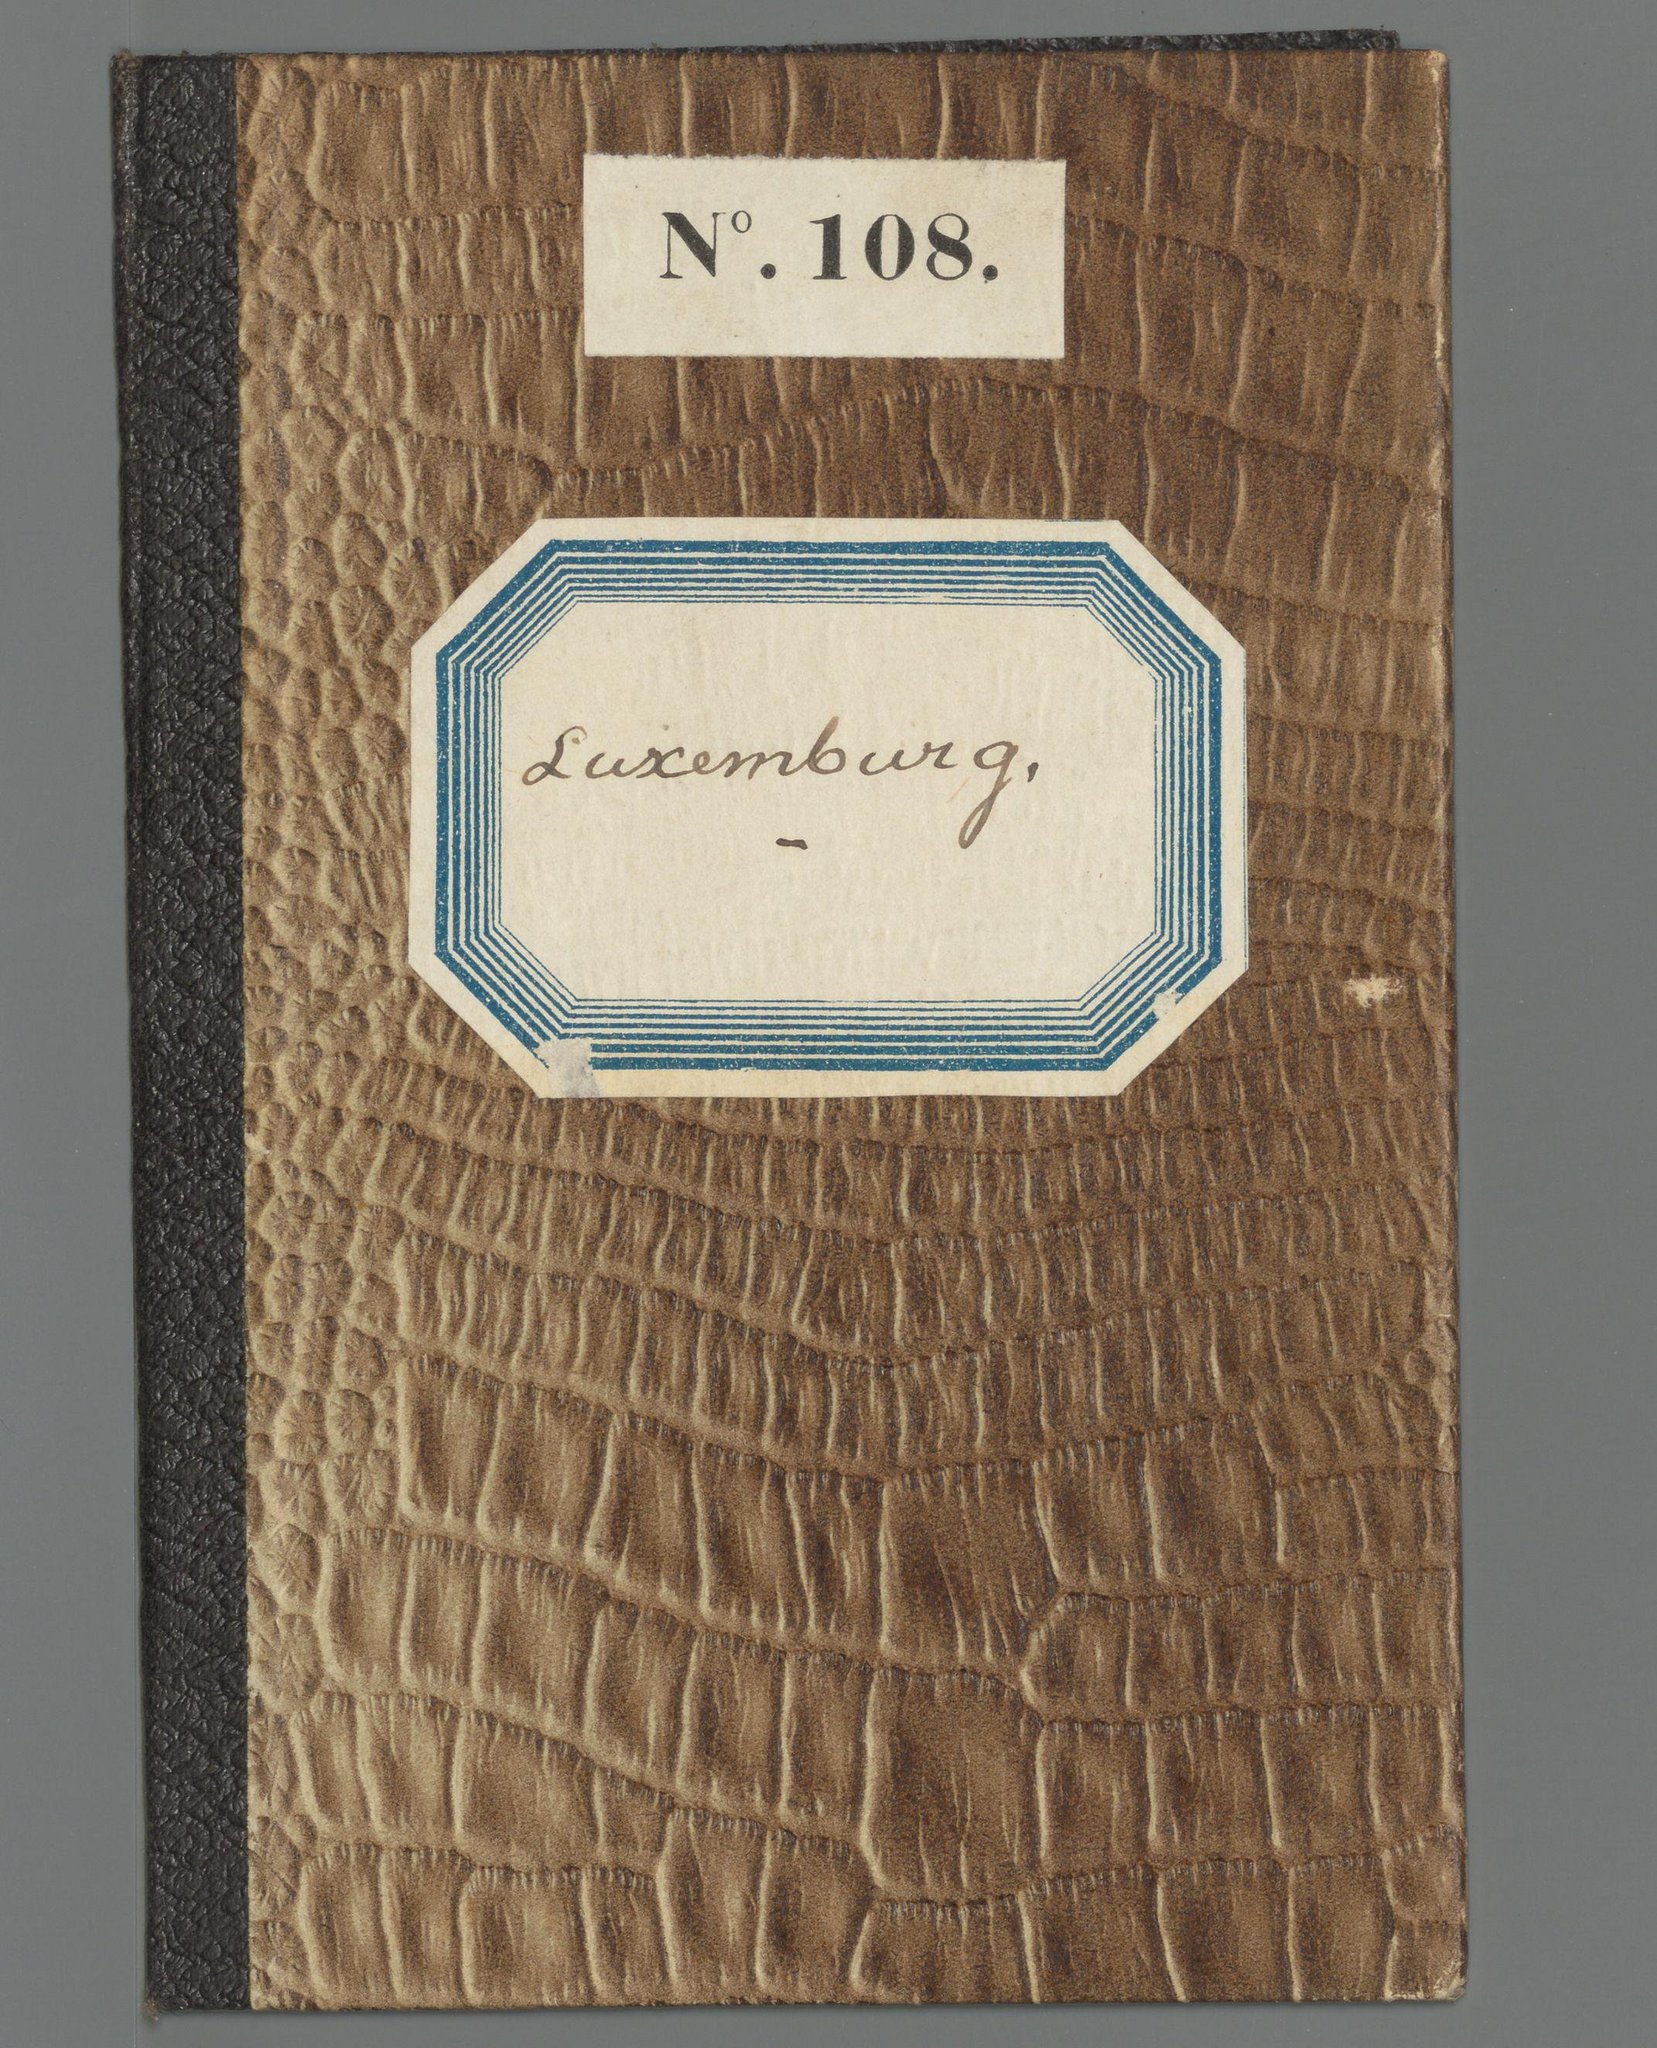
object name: wrapper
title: Omslag voor acht prentbriefkaarten met gezichten uit Luxemburg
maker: Anonymous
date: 1900-1950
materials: cardboard, paper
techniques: lithograph, writing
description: In de omslag zit een kaart ingestoken met daarop een korte beschrijving van de inhoud.